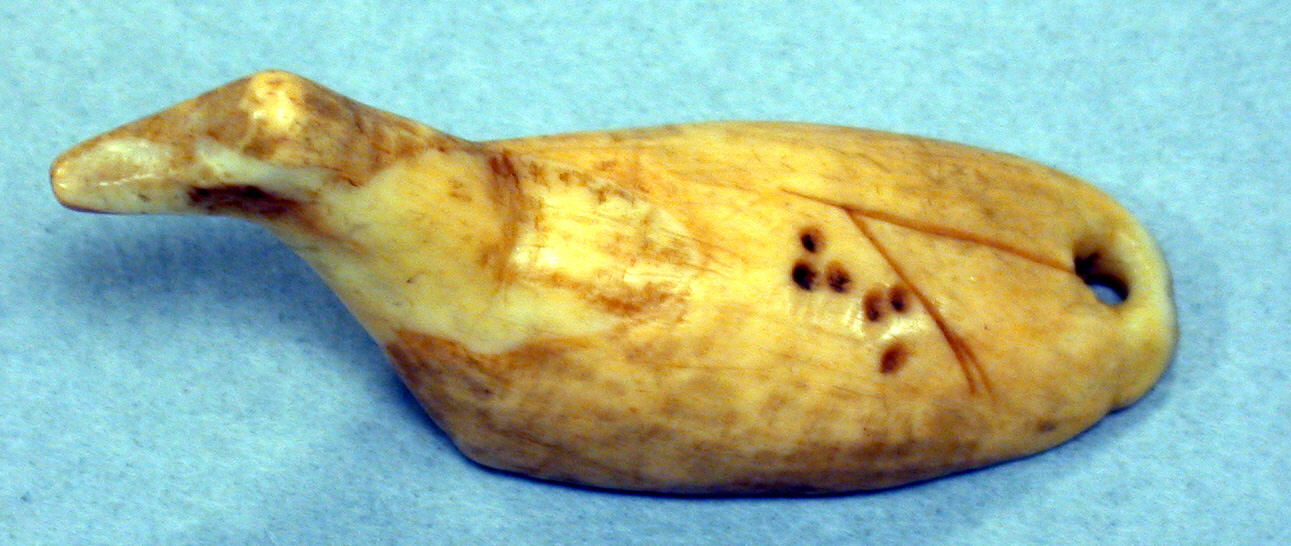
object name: figure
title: Walrus Ivory Animal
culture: inuit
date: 901-1600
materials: ivory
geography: canada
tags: animals